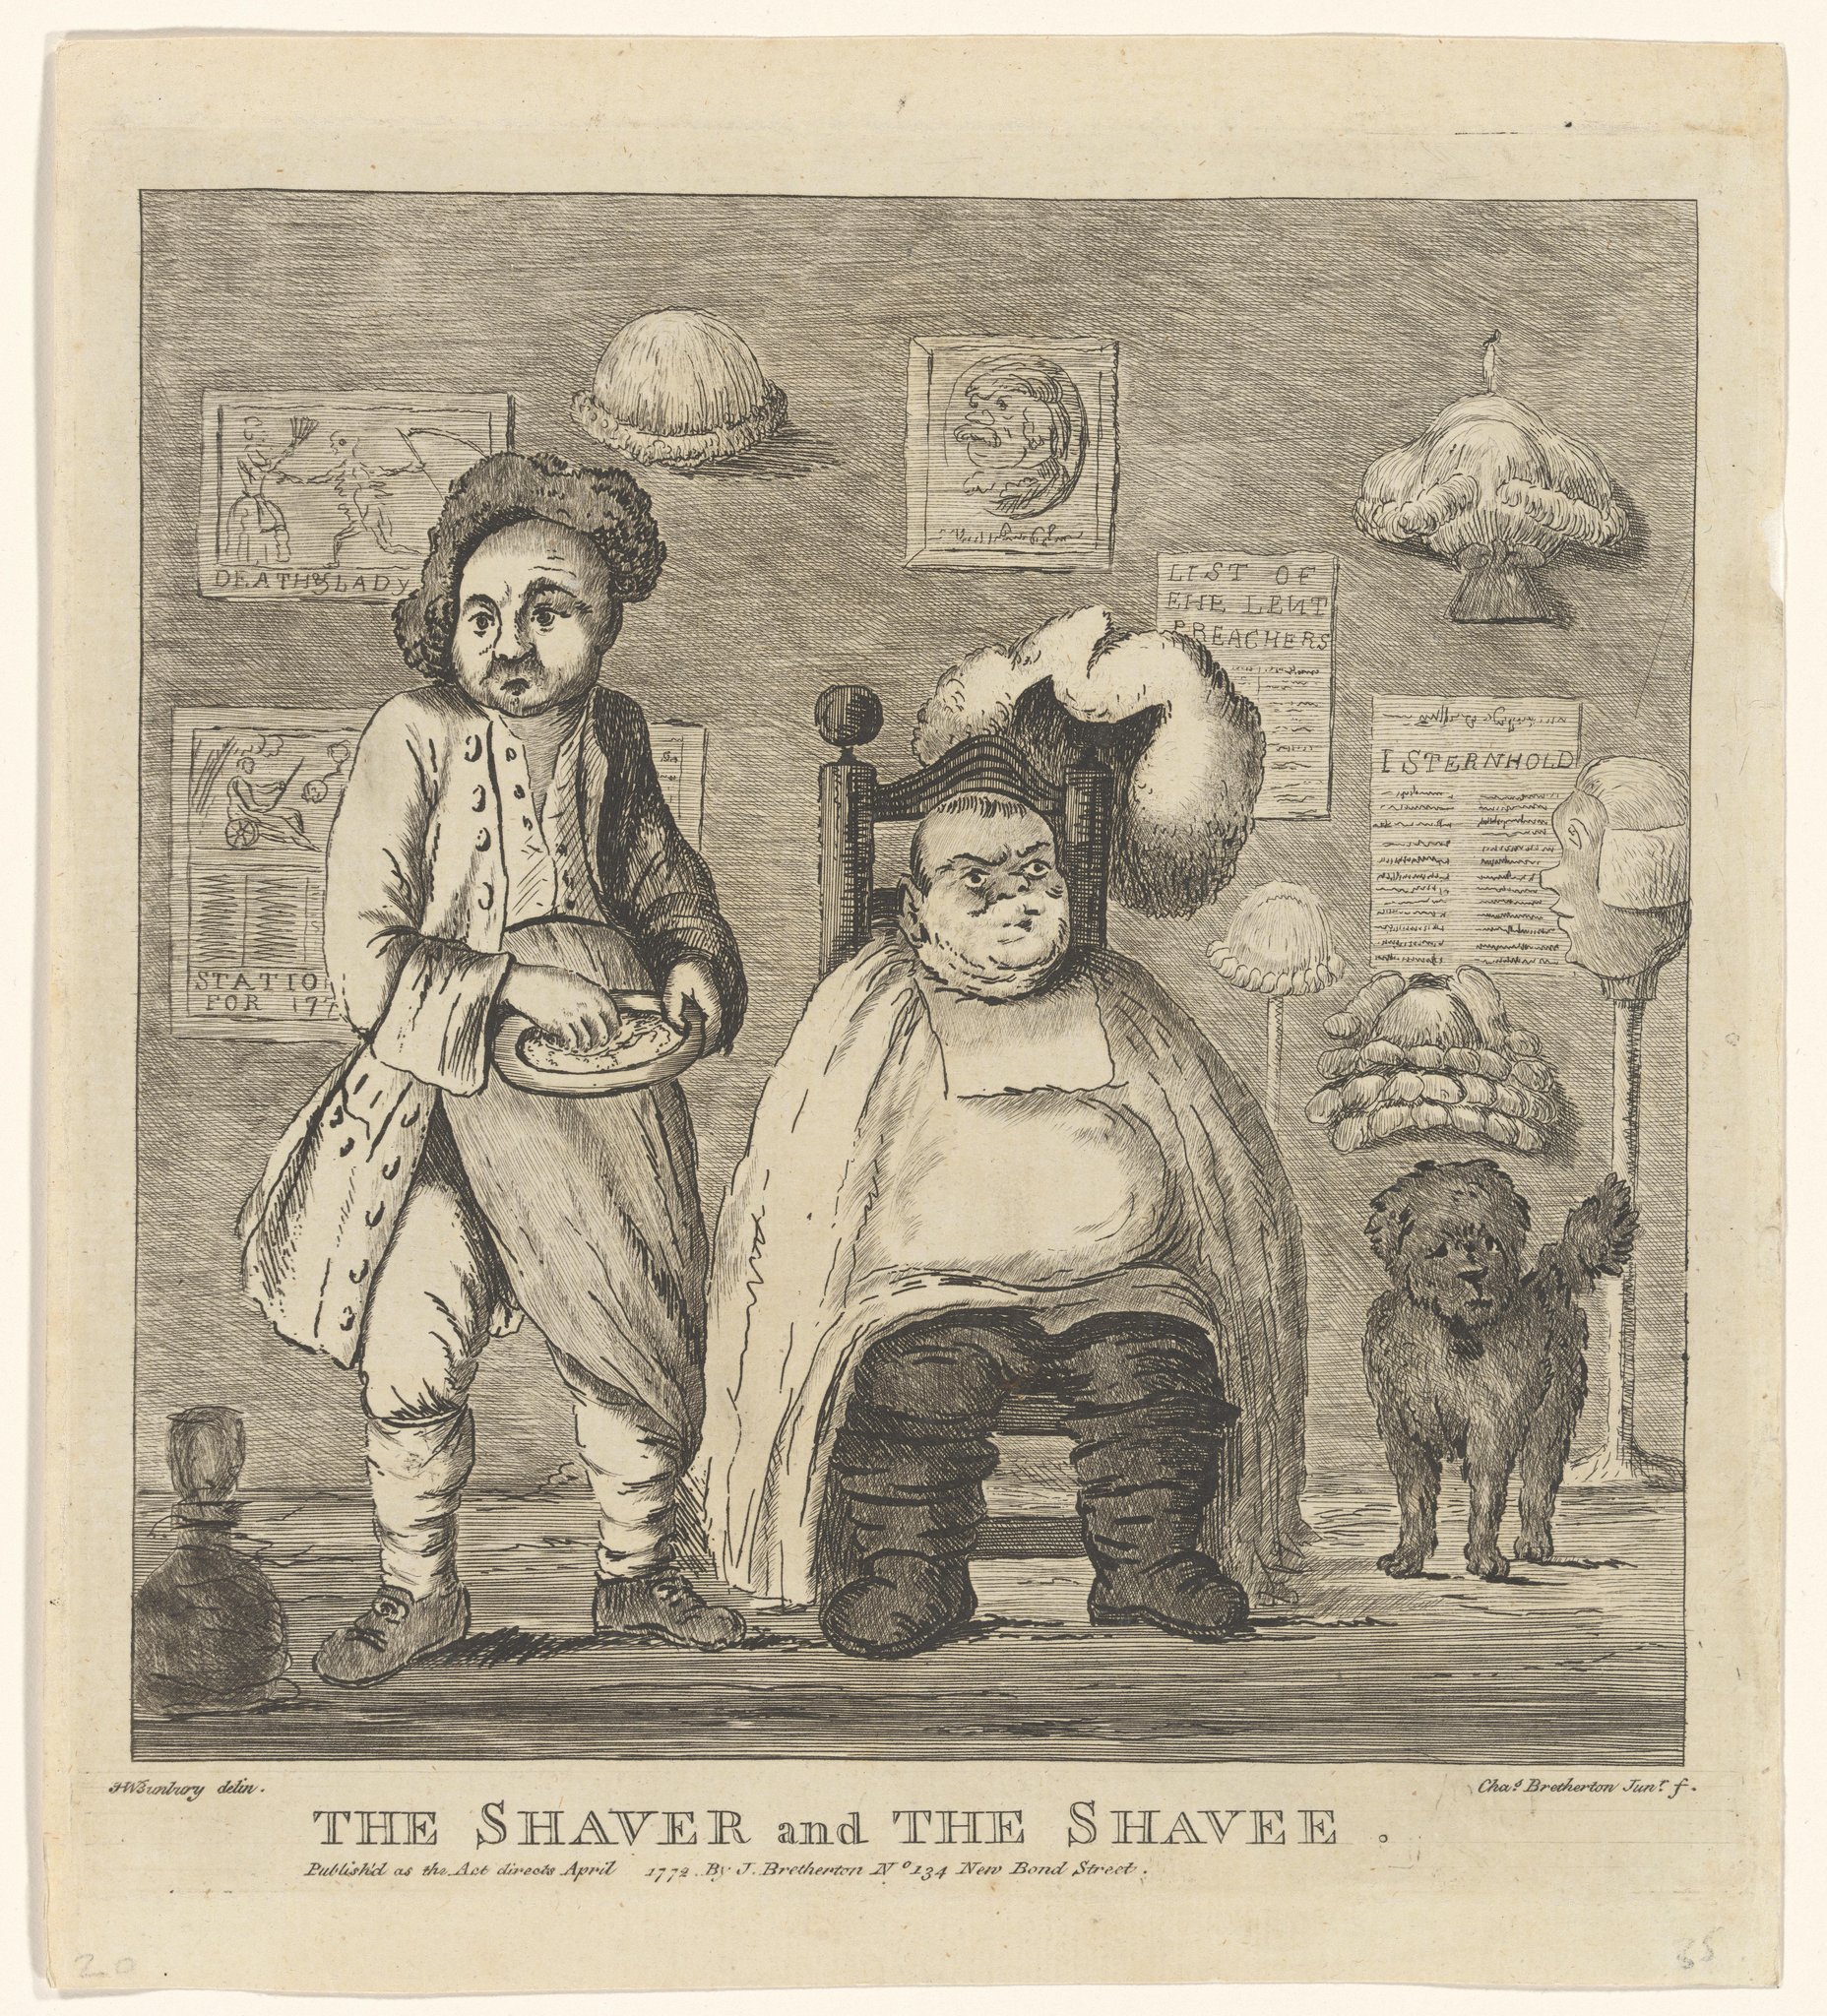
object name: cartoon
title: De barbier en een klant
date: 1774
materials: paper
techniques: etching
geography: london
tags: caricatures (human types), shaving, being shaved, wig, barber, barbershop, dog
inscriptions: collector's mark: Lugt 2228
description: Satire op een kapperszaak. De kapper, met snor en scheve pruik, staat links met zijn hand zeep te mengen in een kom en kijkt bedroefd naar rechts. Een klant zit in de stoel, zijn gezicht al bedekt met schuim, en kijkt weg van de kapper. Zijn grote pruik balanceert op de rugleuning van de stoel en andere pruiken in verschillende stijlen hangen aan de muur of rusten op standaards. Een hond staat naast hem.